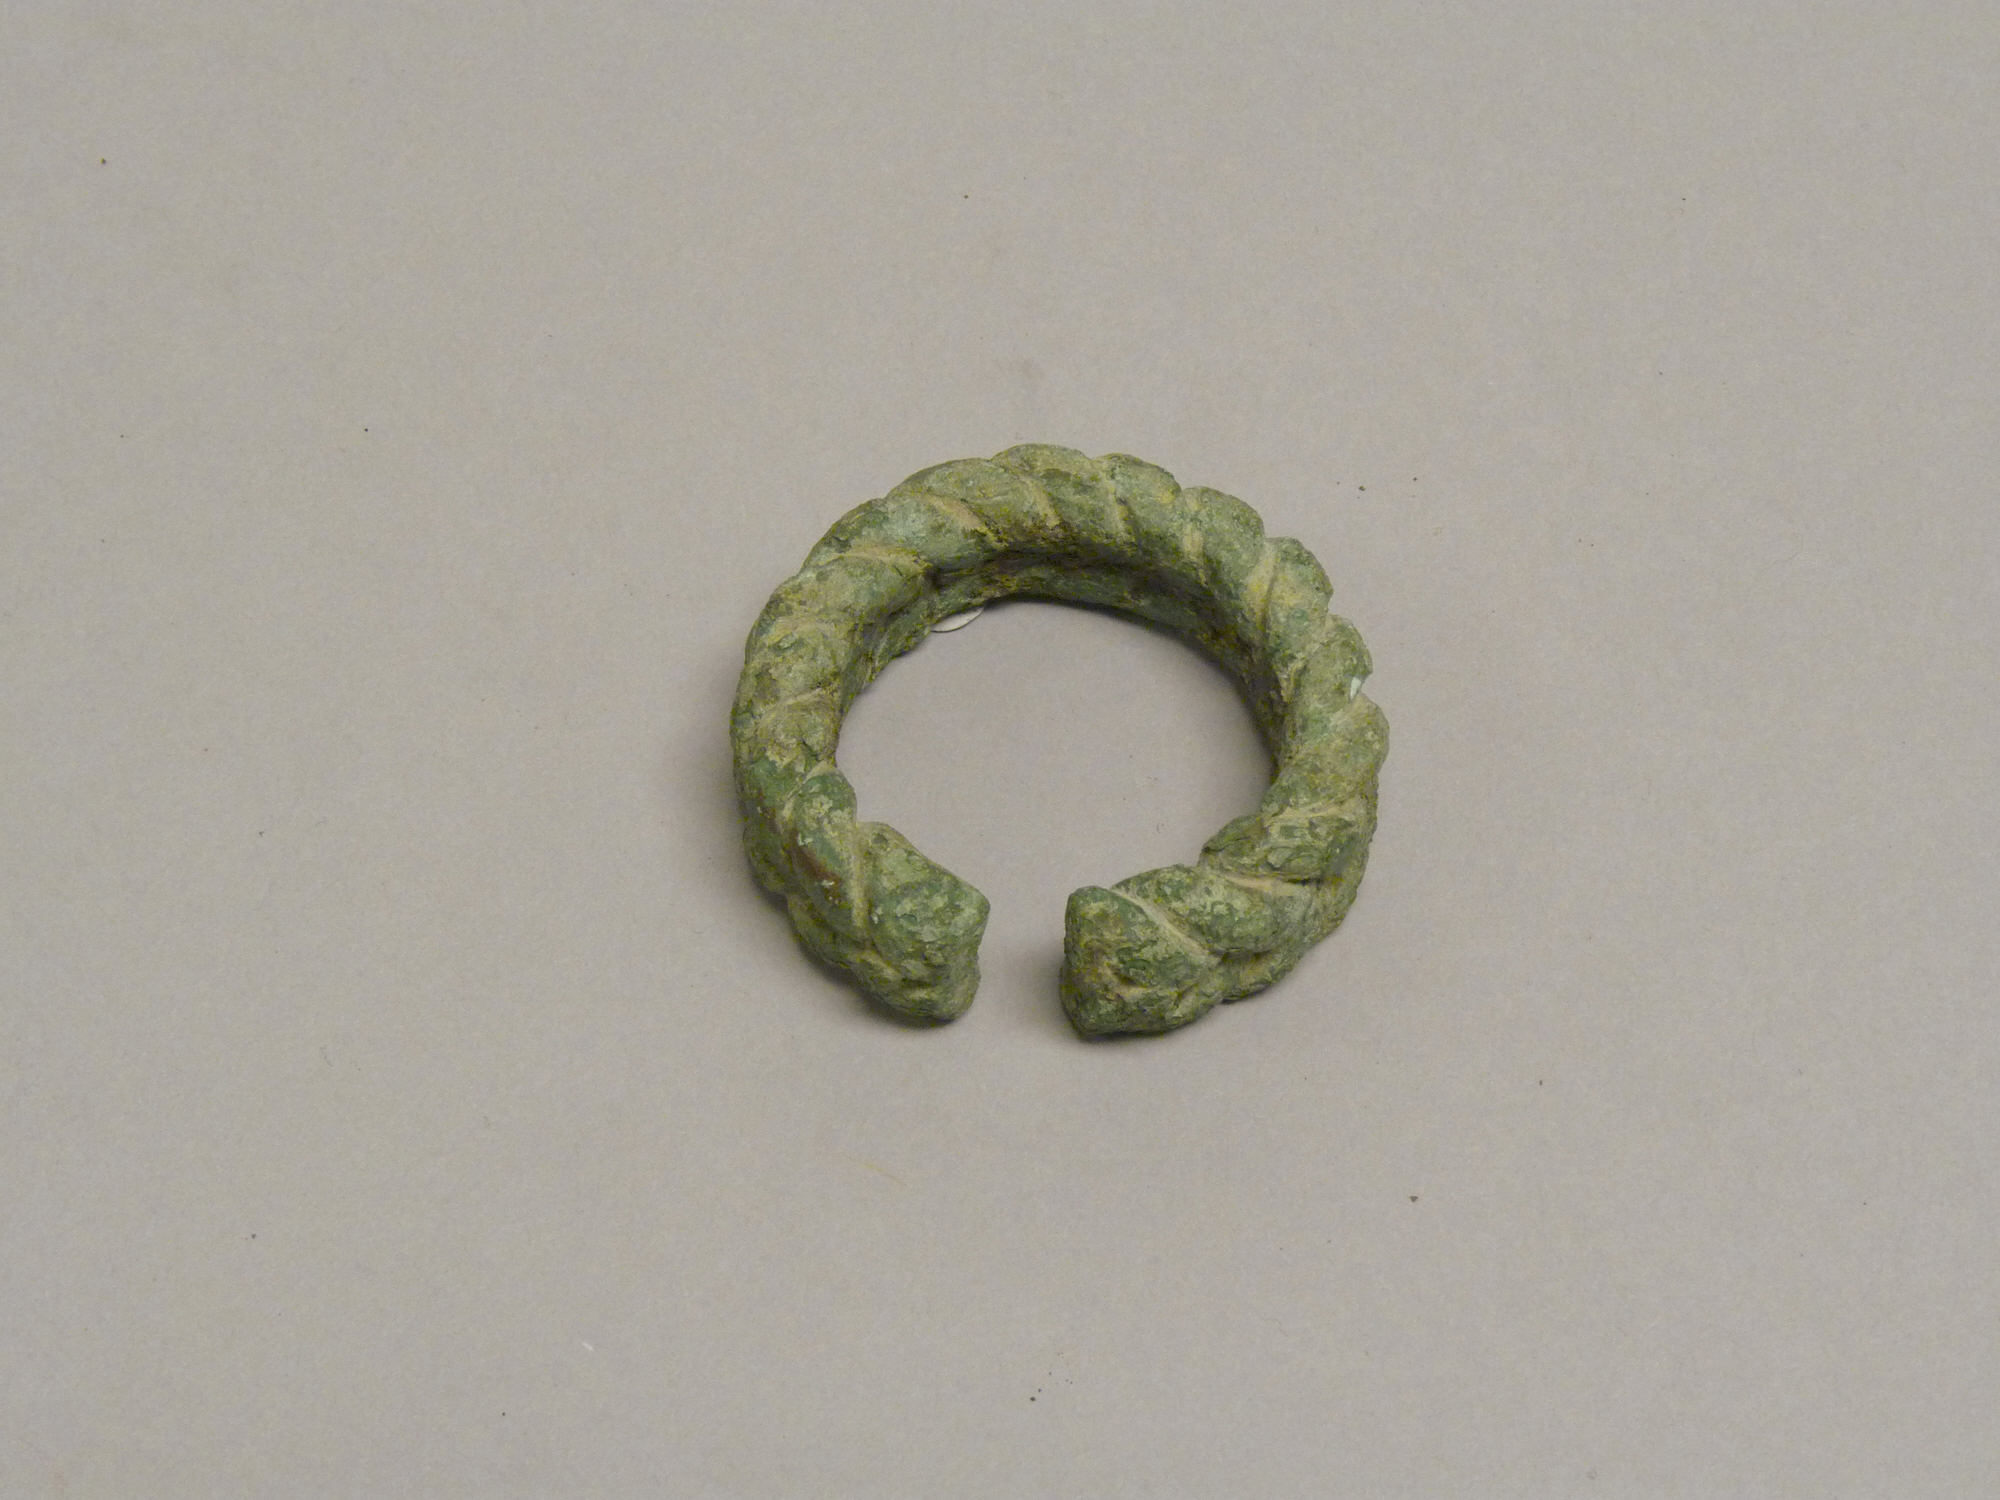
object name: bracelet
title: Solid Bracelet with Large Braid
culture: thai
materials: bronze